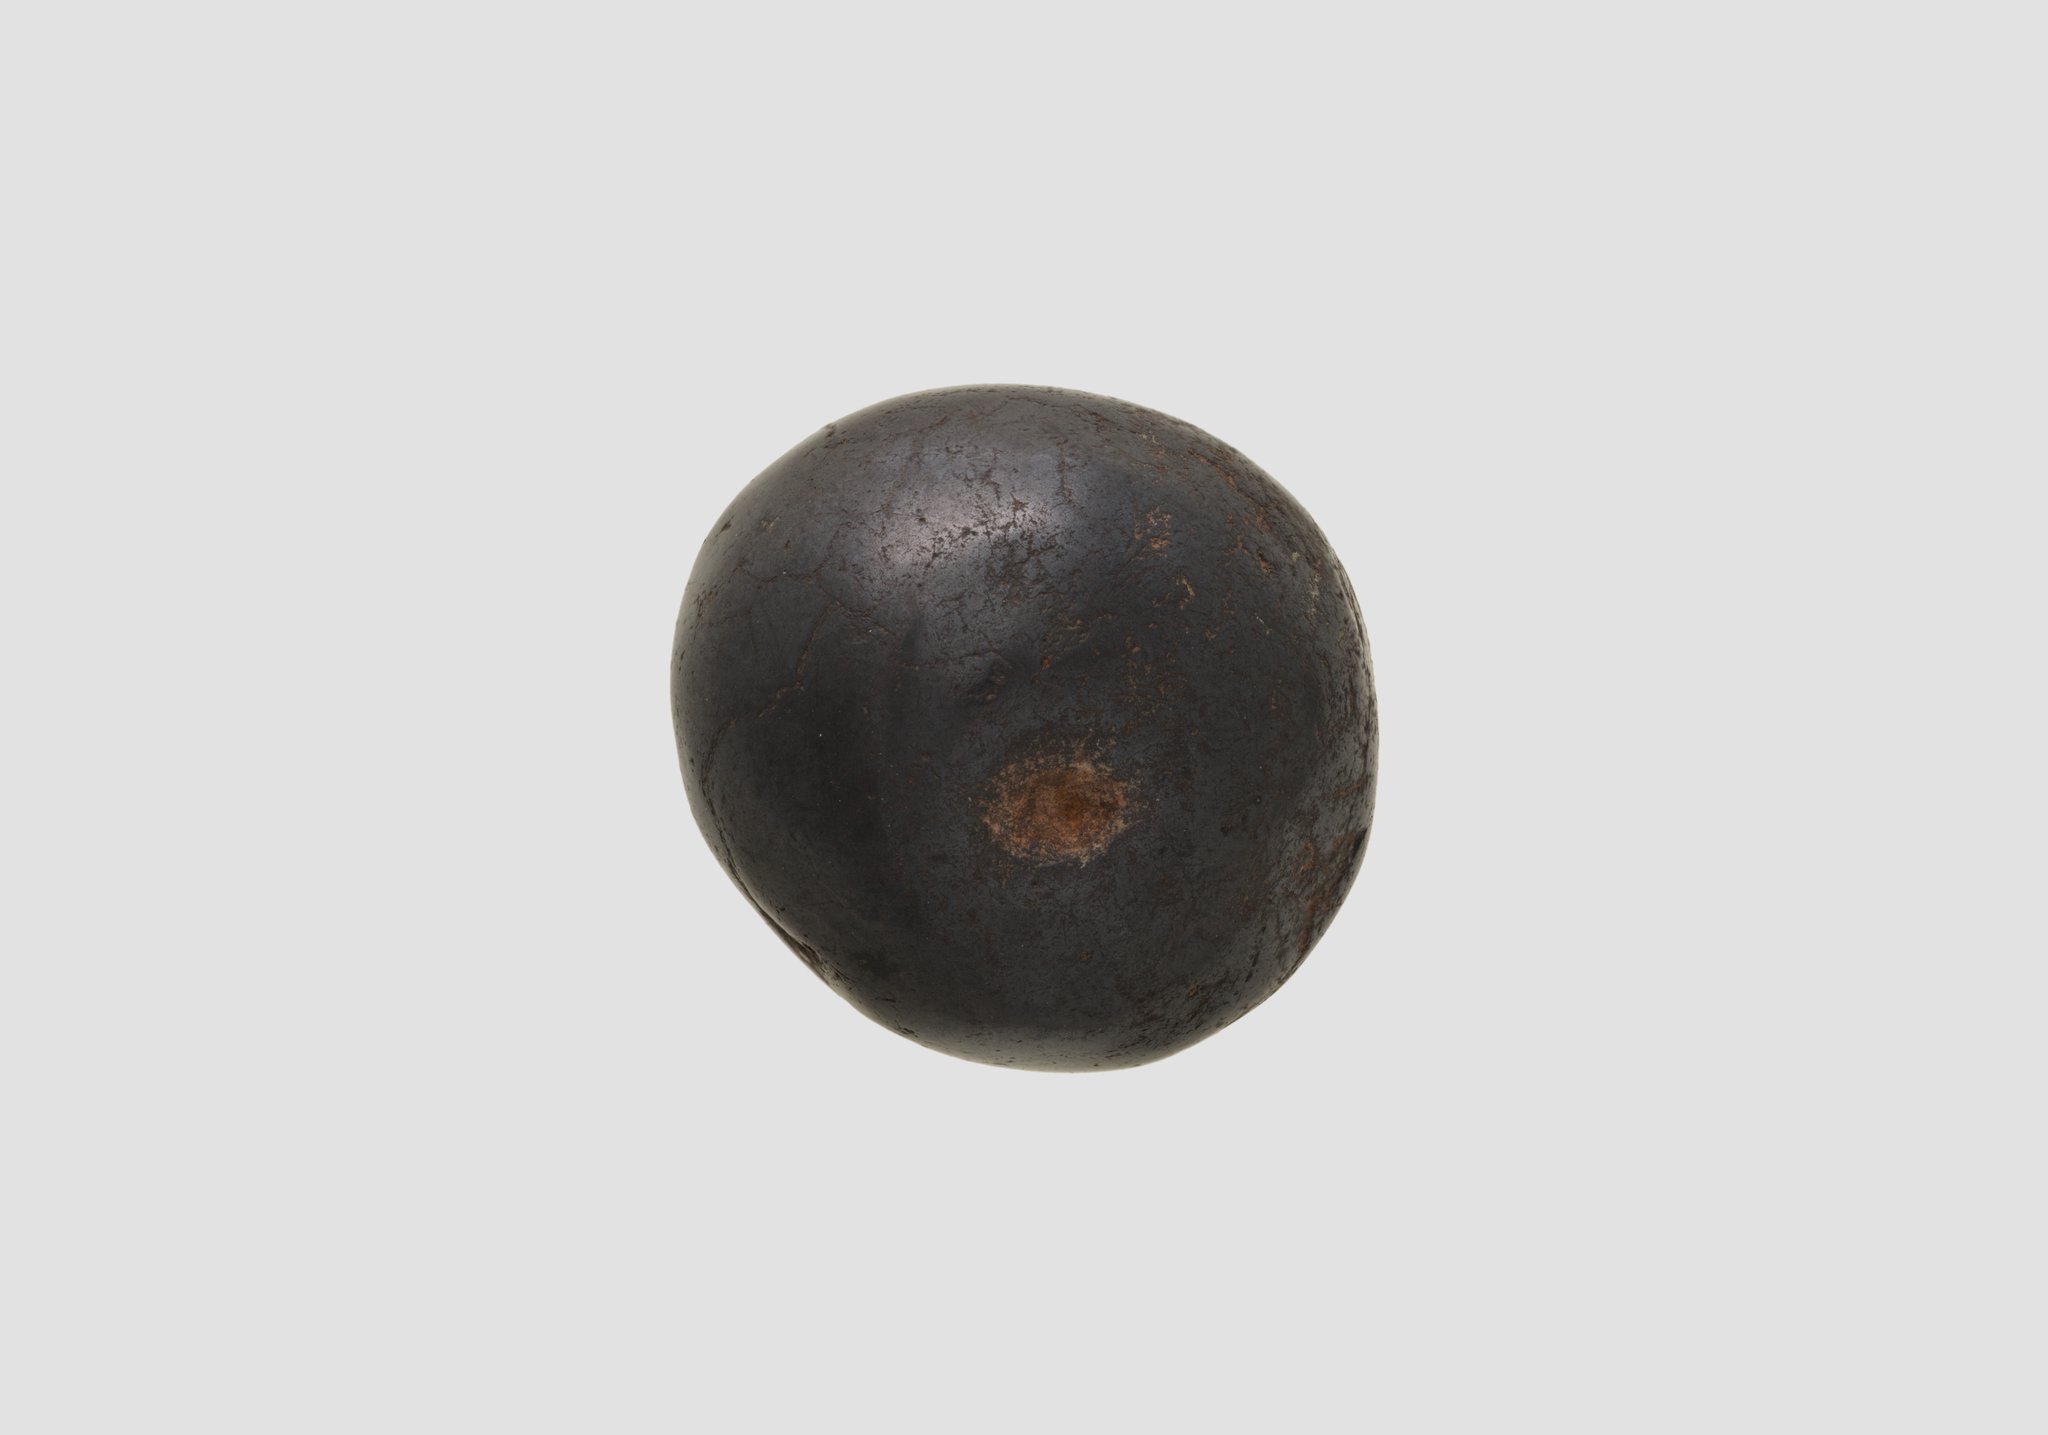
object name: weight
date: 3000-1 BCE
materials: mineral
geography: cyprus or western asia